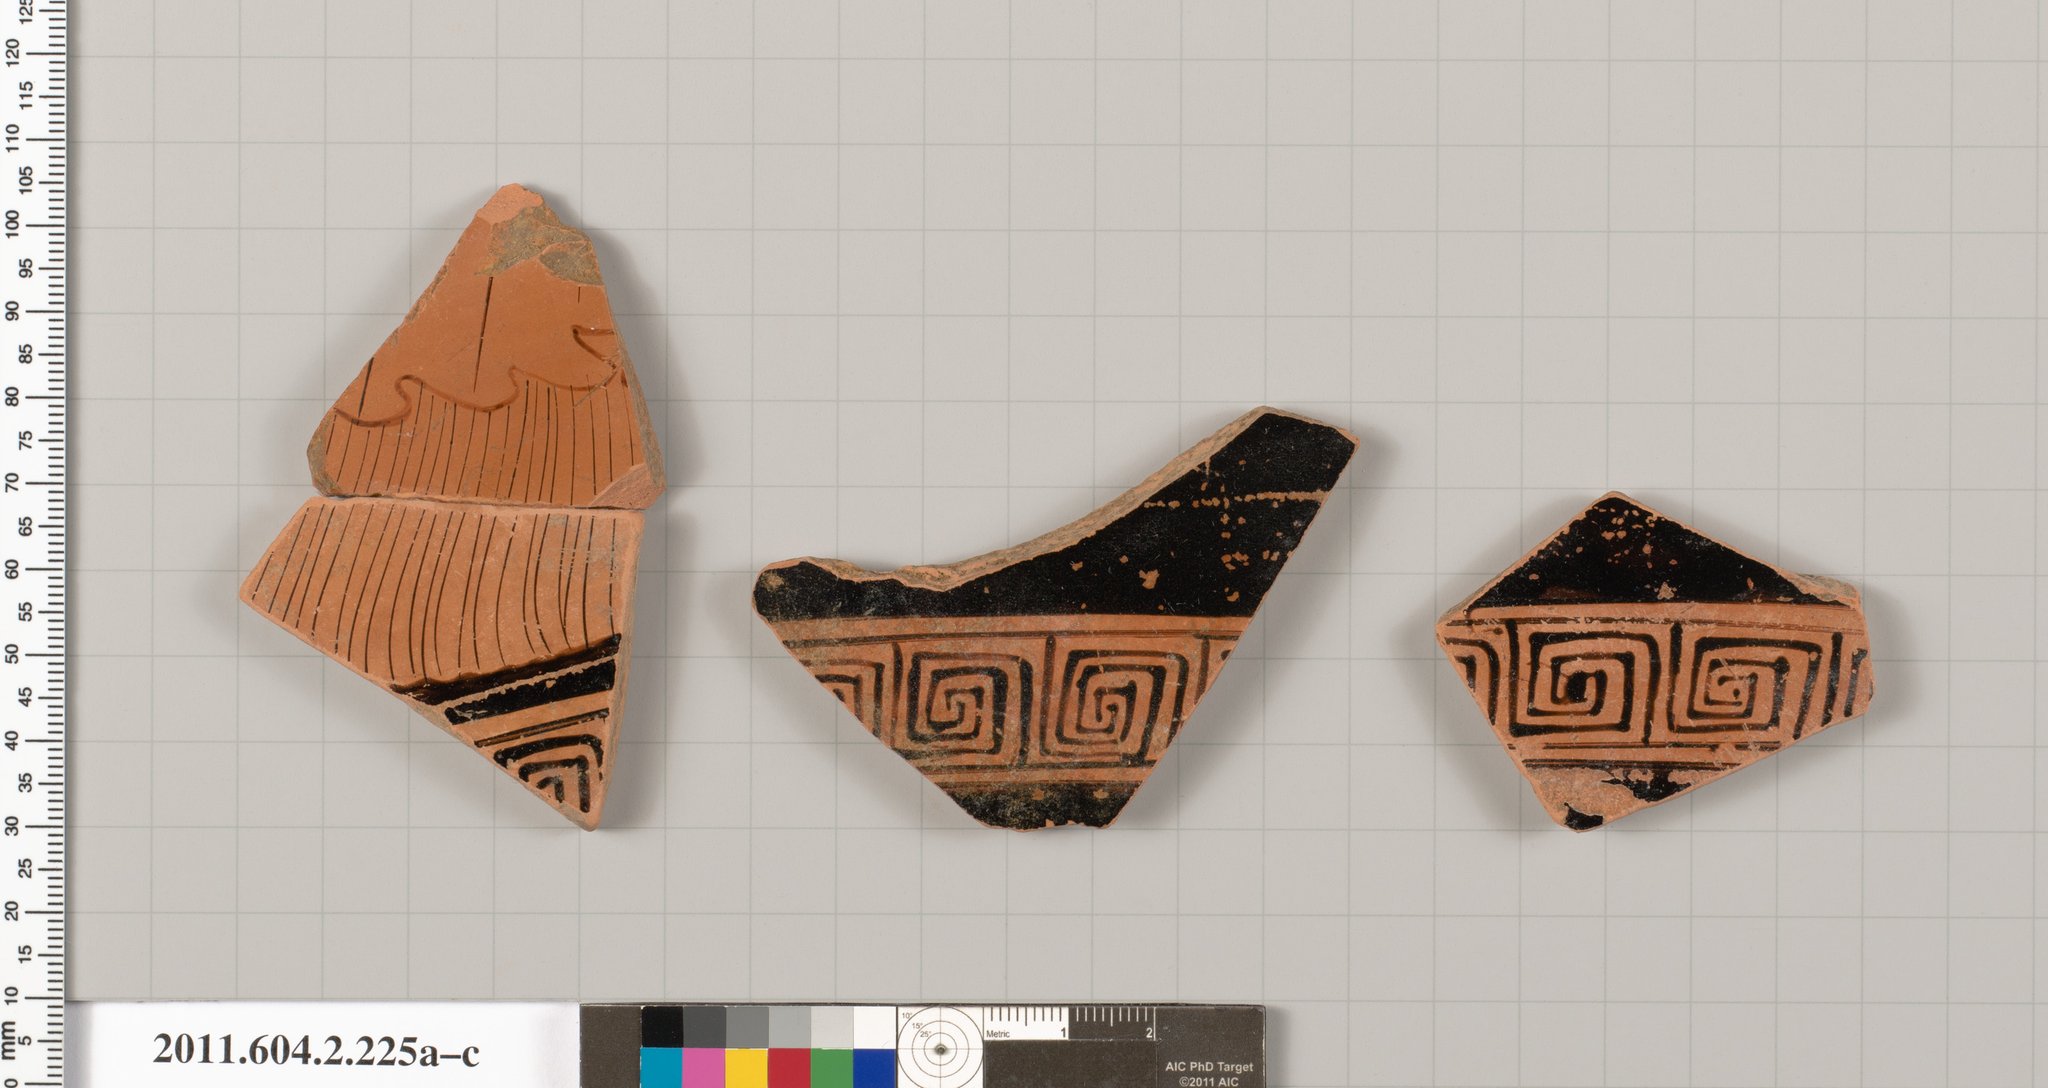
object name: stamnos fragment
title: Terracotta fragments of a stamnos (jar)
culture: greek, attic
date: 460-440 BCE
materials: terracotta